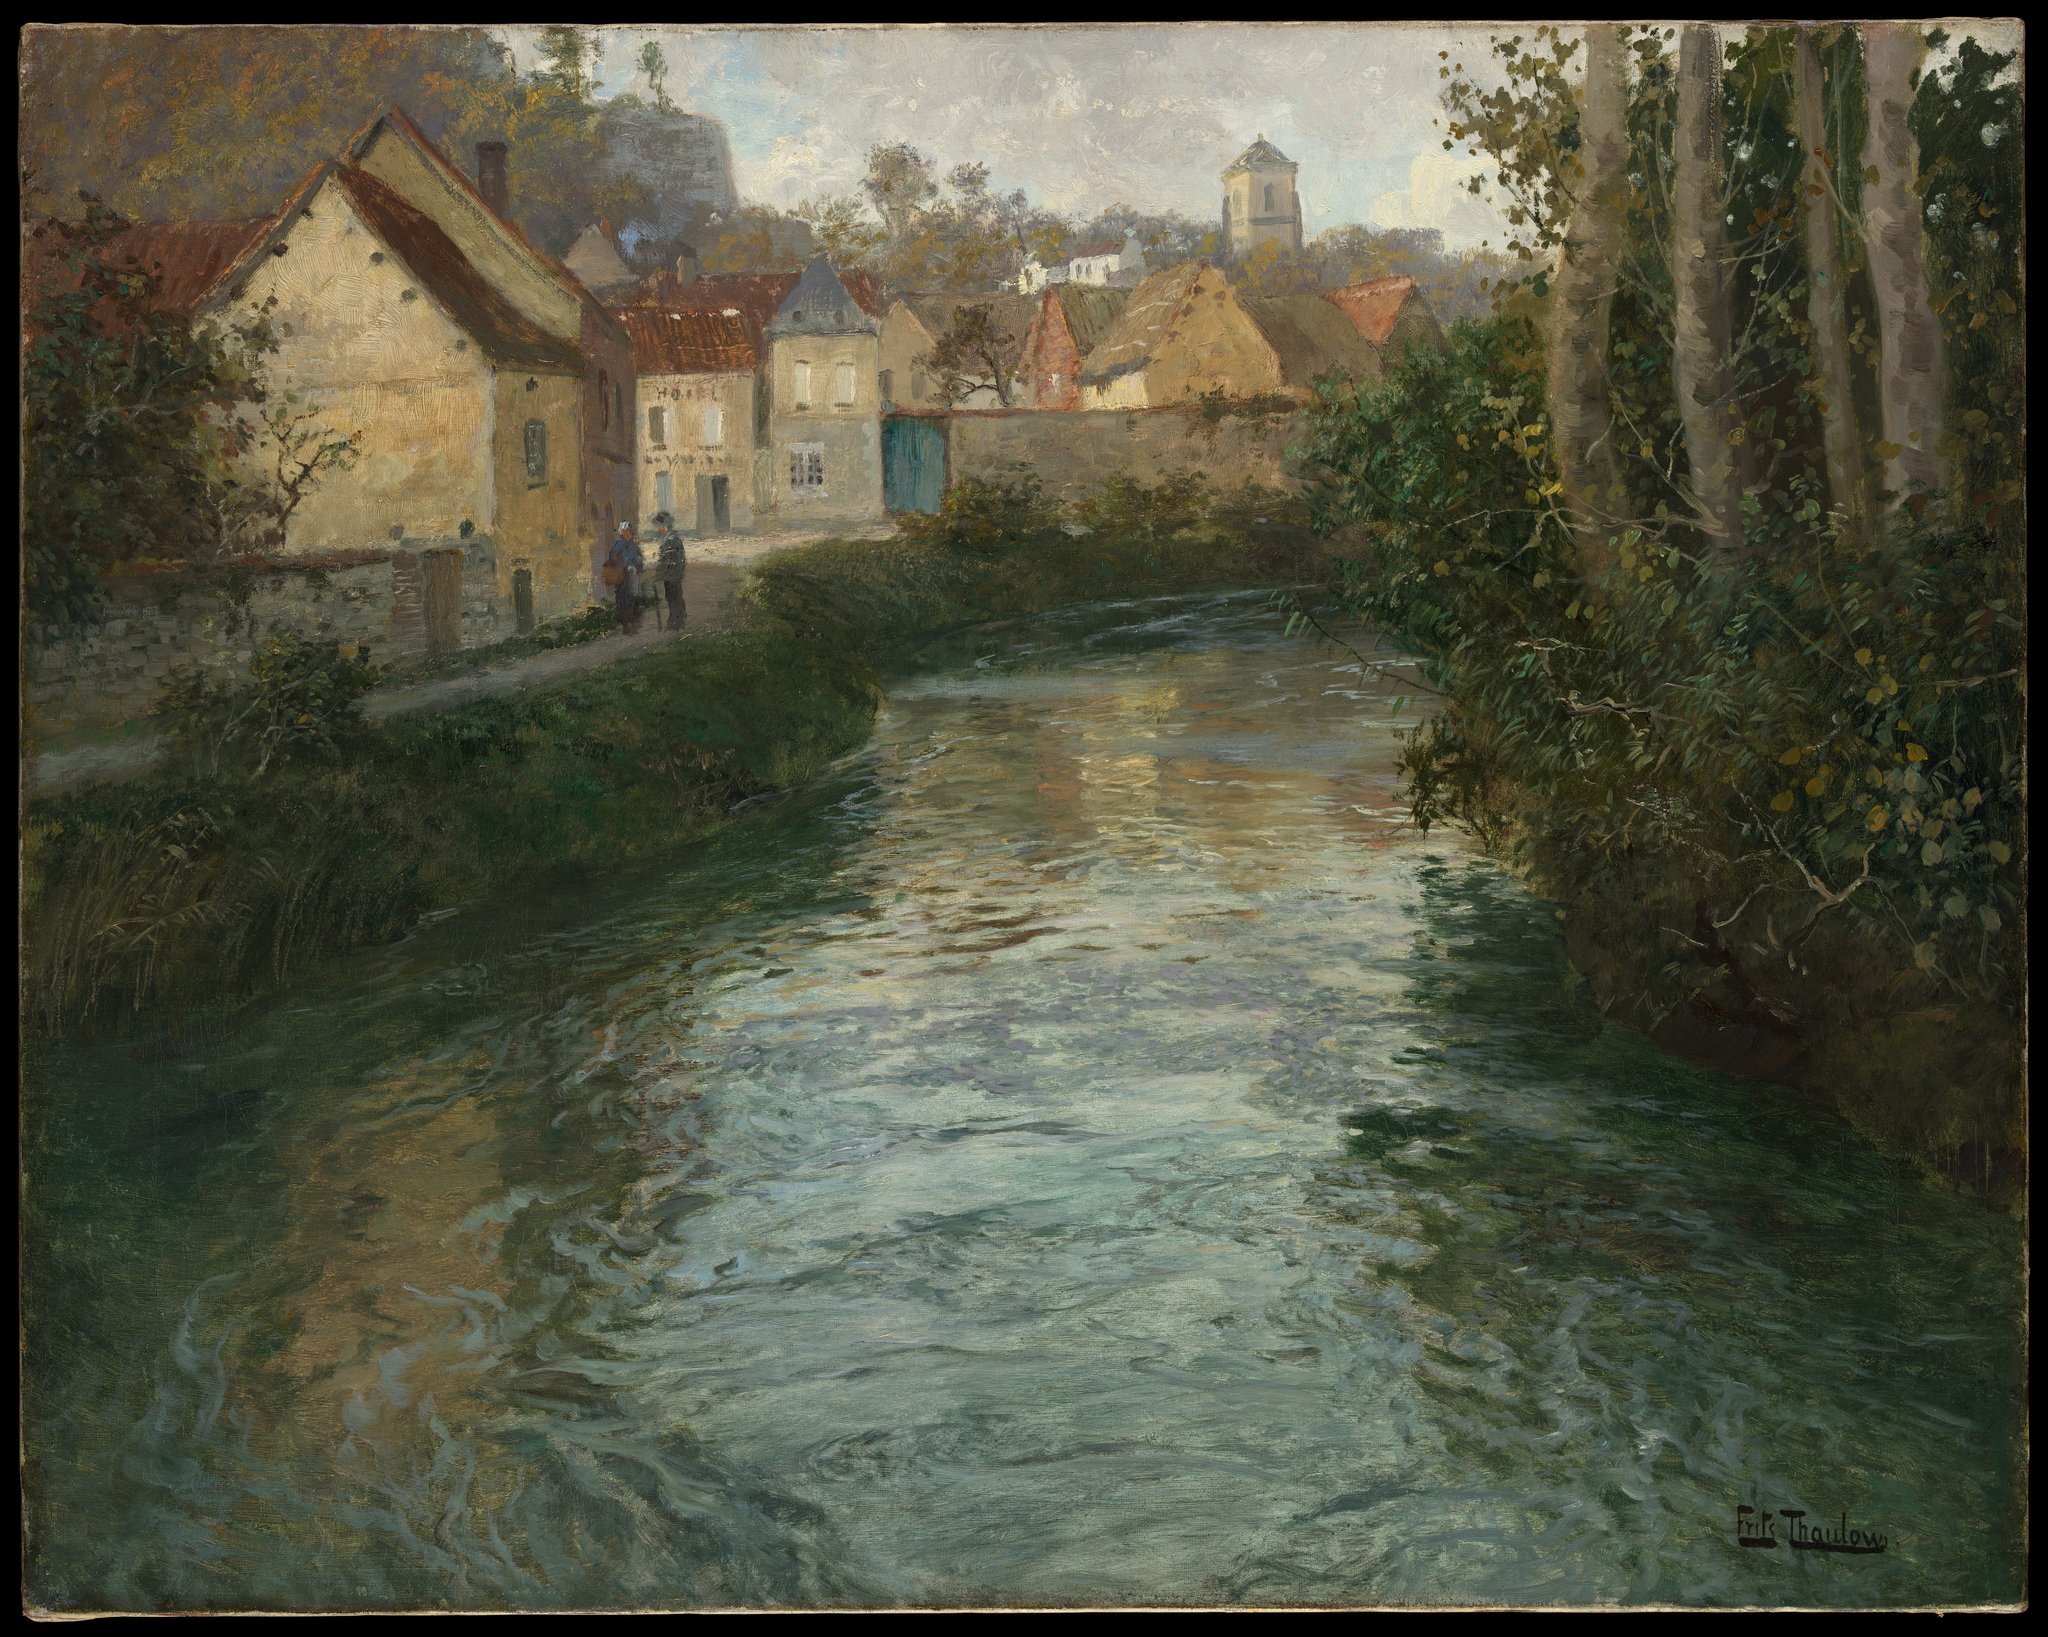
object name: painting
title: Picquigny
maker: frits thaulow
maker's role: artist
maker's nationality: norwegian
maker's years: 1847-1906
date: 1899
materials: canvas, oil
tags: villages,rivers